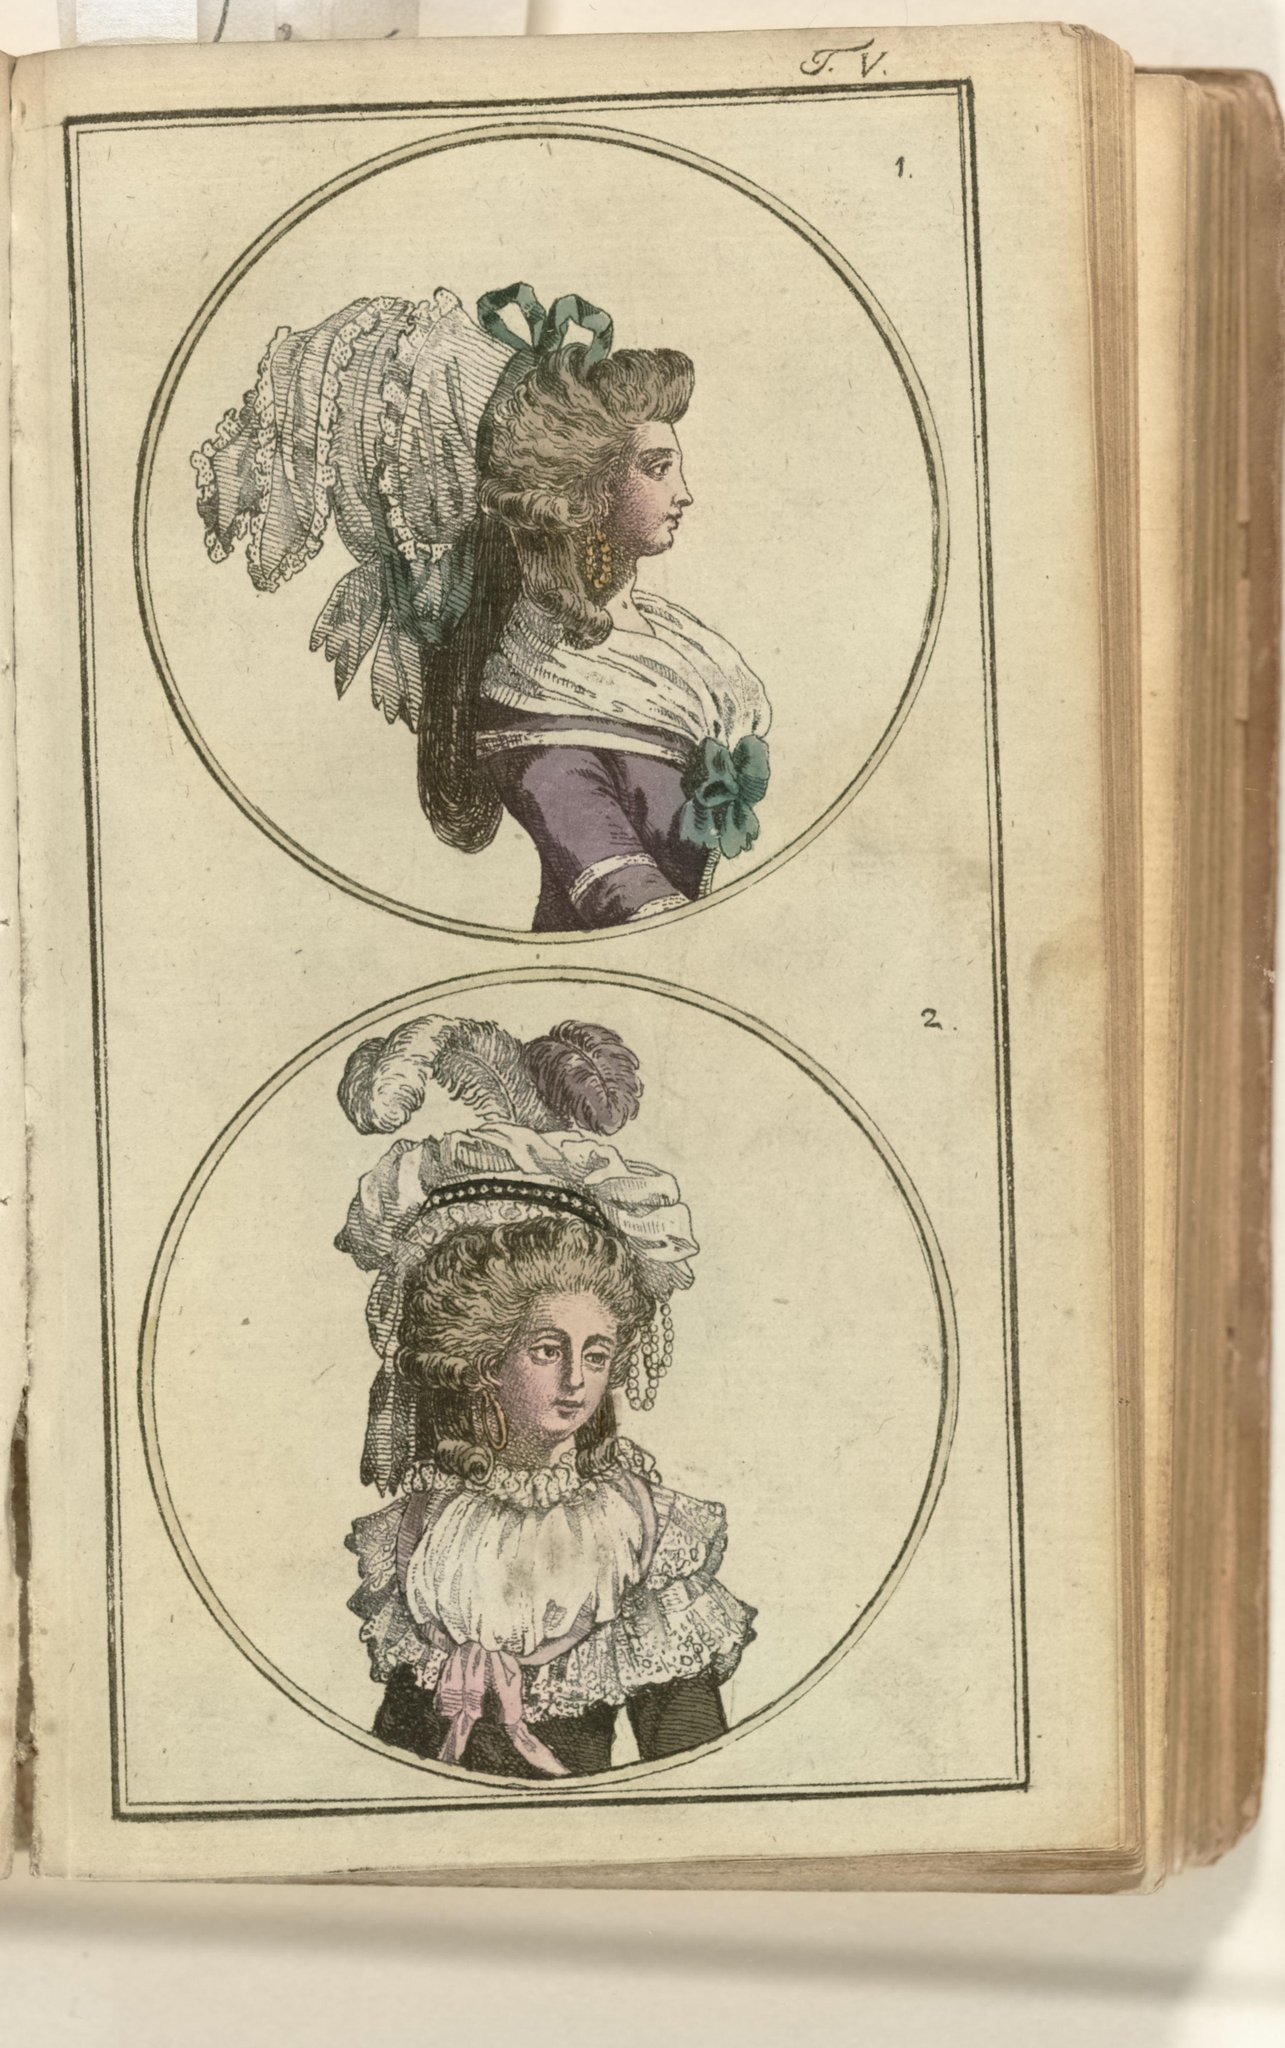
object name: fashion print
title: Journal des Luxus und der Moden 1786, Band I, T. 5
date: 1786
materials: paper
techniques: etching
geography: weimar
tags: ring (+ women's clothes), head-gear (bonnet à la figaro) (+ women's clothes), head-gear: cap (+ women's clothes), neck-gear: collar (+ women's clothes), fashion plates, piece of clothing covering the breast or décolleté (fichu) (+ women's clothes)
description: Twee vrouwenbustes in cirkels onder elkaar met een nieuw type bonnet en nieuwe fichu's. Boven: Muts 'à la Laitière', oorbellen 'en plaquettes' , eenvoudig fichu. Onder: Bonnet 'à la Figaro' met een witte en een paarse veer en parelsnoeren. Fichu 'en gorge angloise'. Oorbellen "anneaux unis'. Prent uit het modetijdschrift Journal des Luxus und der Moden, uitgegeven door Friedrich Justin Bertuch en Georg Melchior Kraus, Weimar, 1786-1826.